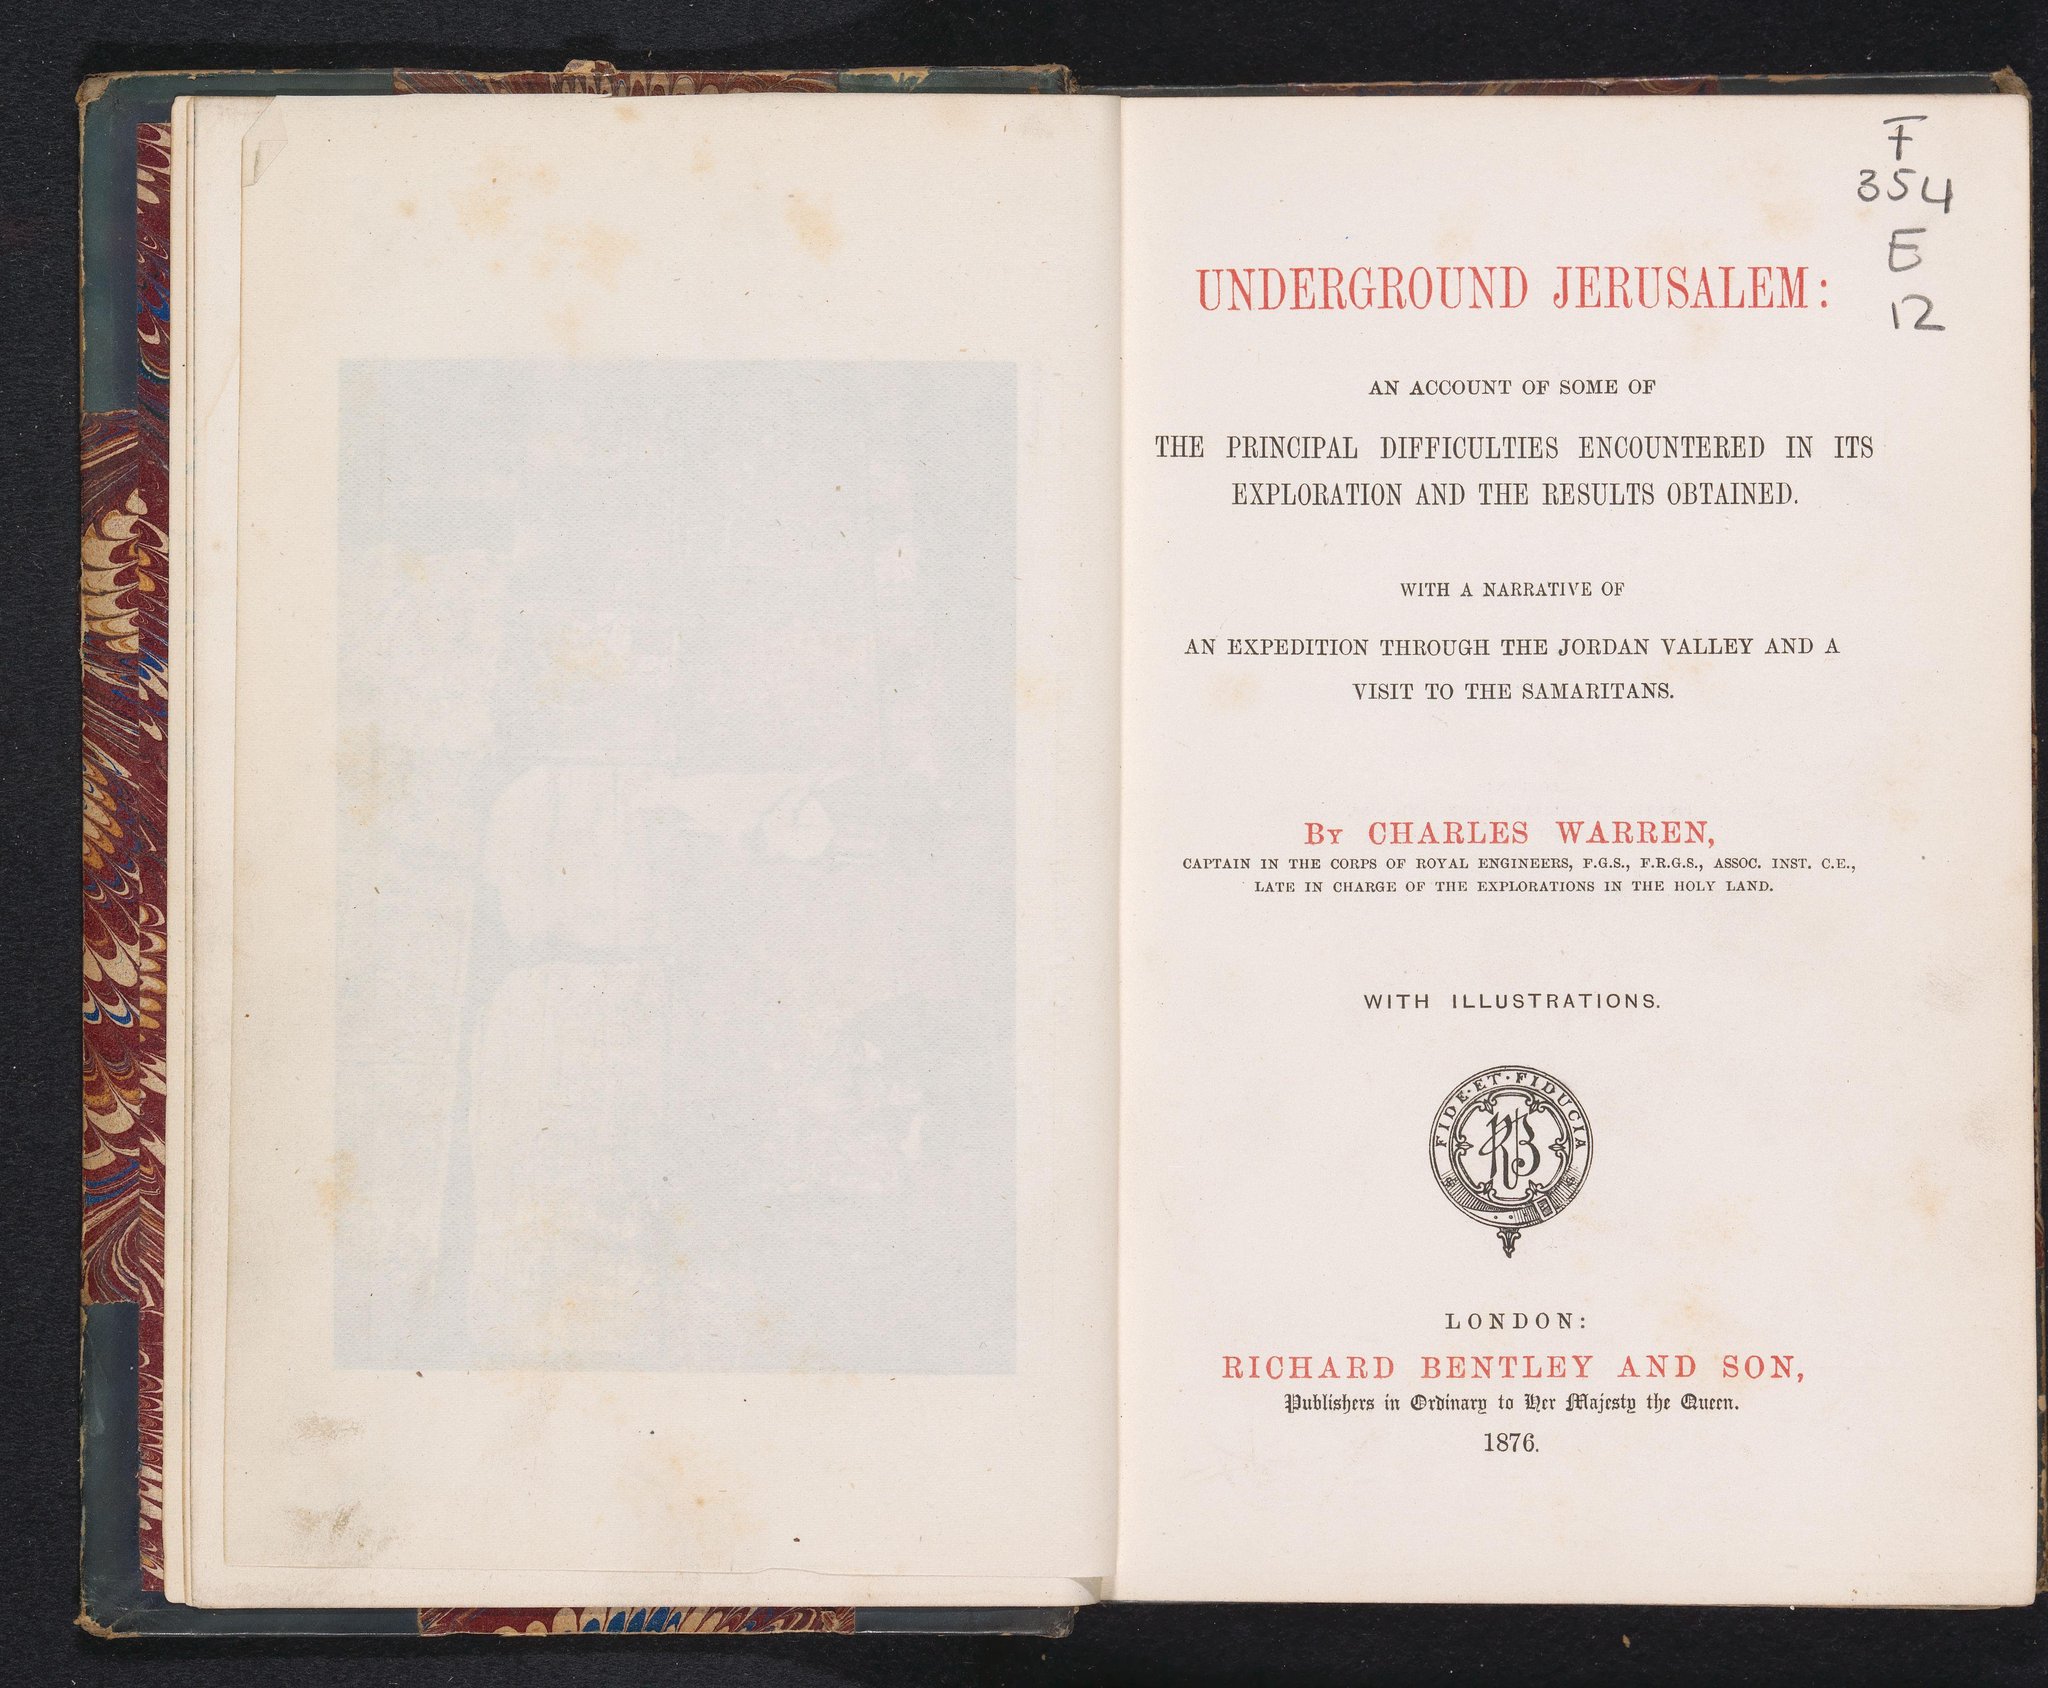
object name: book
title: Underground Jerusalem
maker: charles warren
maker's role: engineer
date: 1876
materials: cardboard, leather, paper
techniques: combed marbled paper, lithograph, printing, woodburytype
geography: london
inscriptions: inscription: ‘Edward Brown Lees and Dorothy Libesey his Wife’